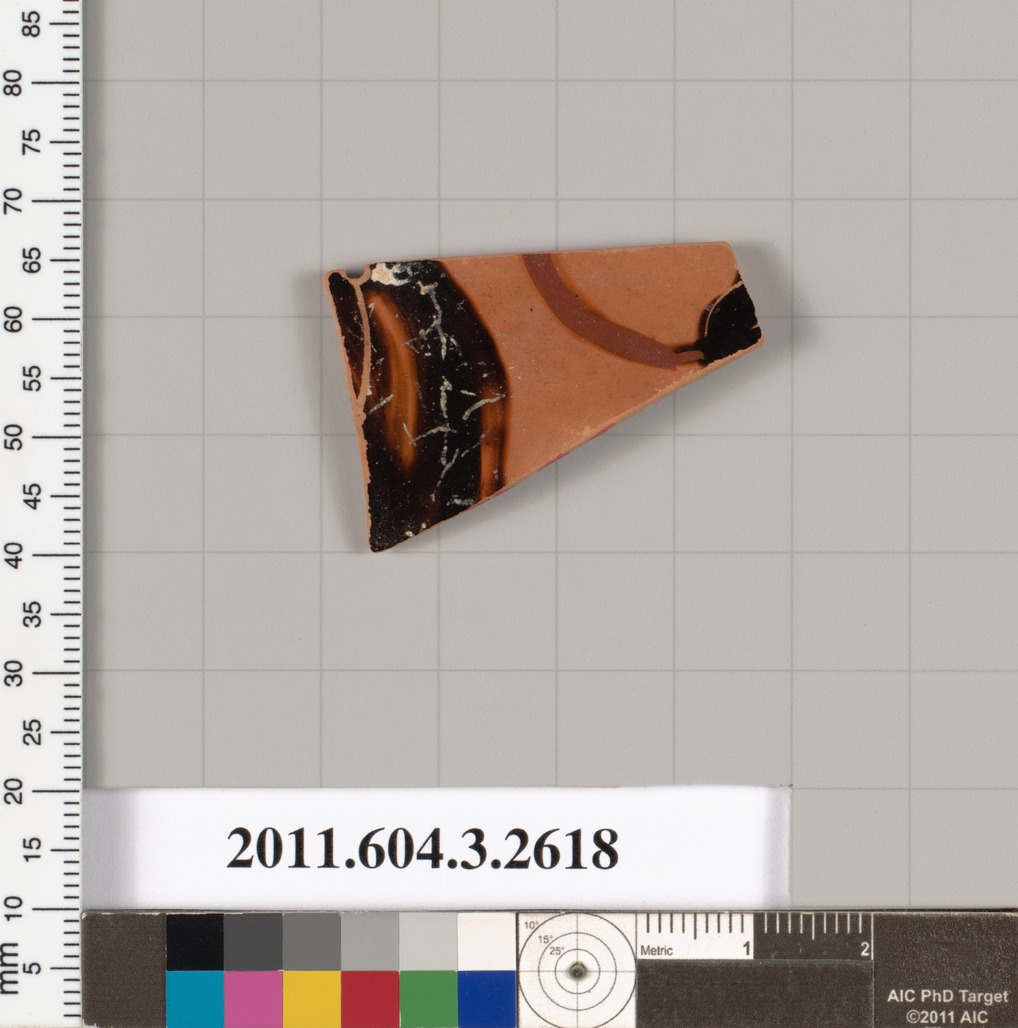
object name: kylix fragment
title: Terracotta fragment of a kylix (drinking cup)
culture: greek, attic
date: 550-501 BCE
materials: terracotta